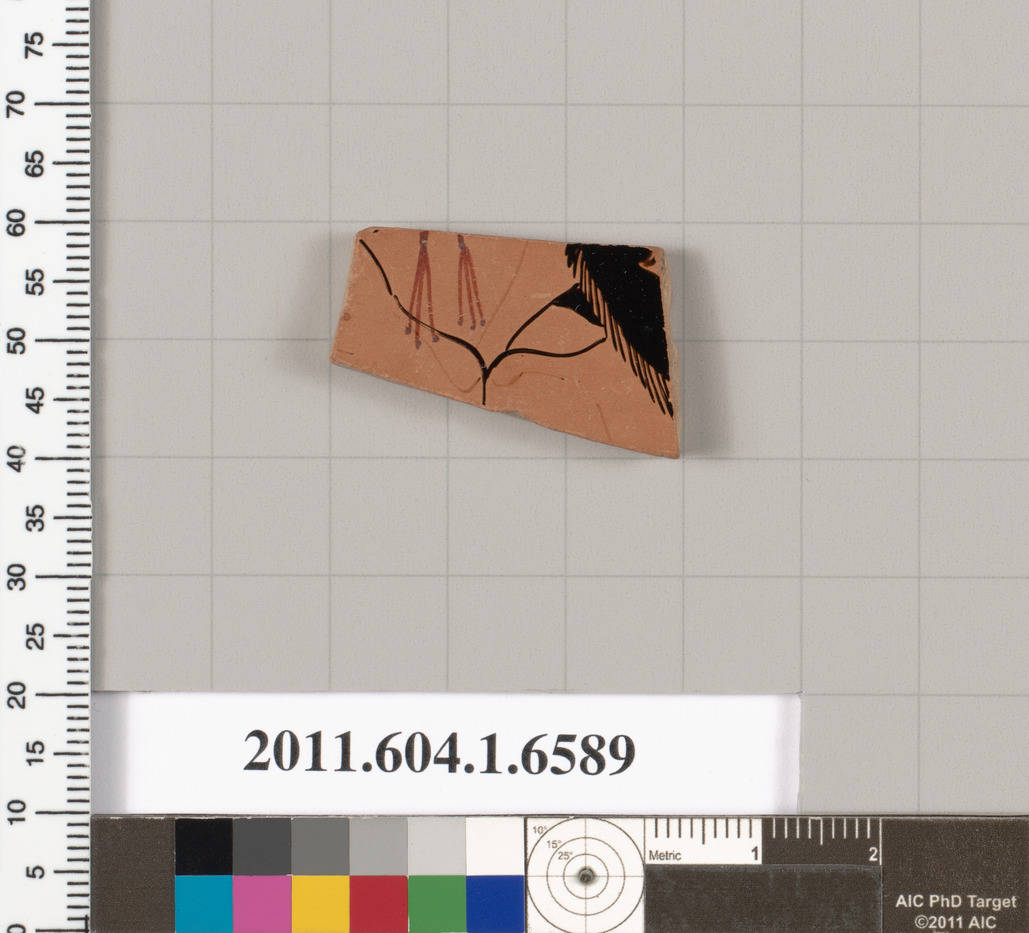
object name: kylix fragment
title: Terracotta fragment of a kylix (drinking cup)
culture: greek, attic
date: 490-480 BCE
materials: terracotta